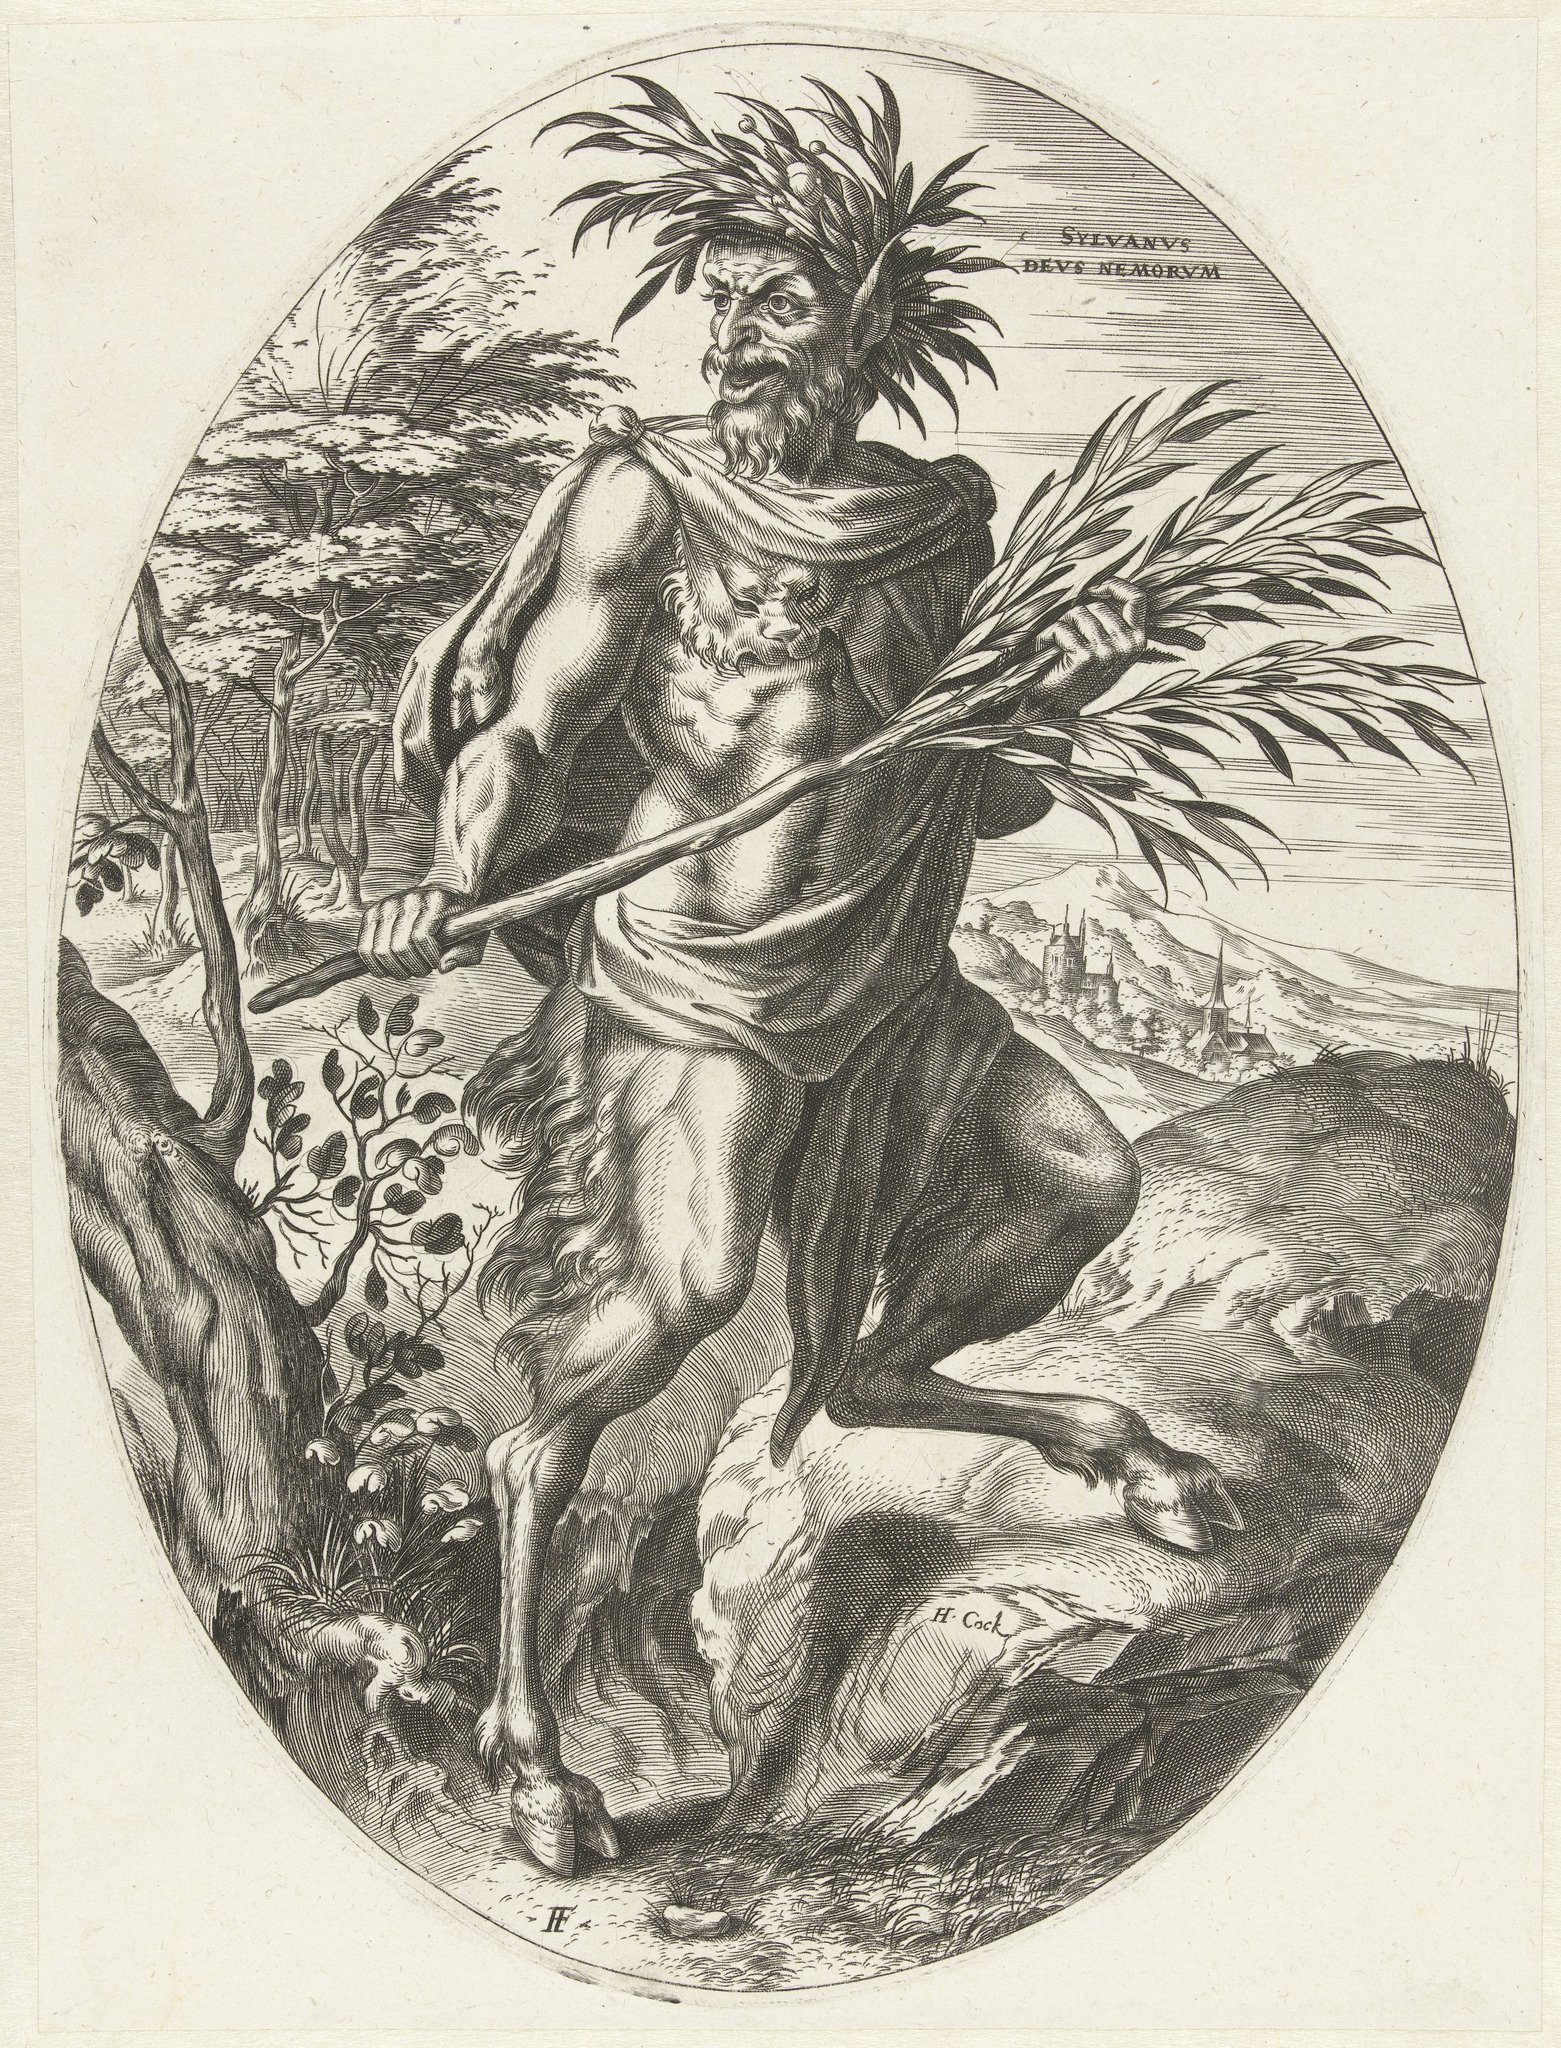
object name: print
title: Goden van de landbouw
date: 1565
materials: paper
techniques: engraving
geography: antwerp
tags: silvanus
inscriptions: collector's mark: Lugt 2228, collector's mark: Lugt 2542, collector's mark: Lugt 1379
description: De sater Sylvanus is de vertegenwoordiger van woud en bos in deze serie van zes prenten met goden voor land en akkerbouw.